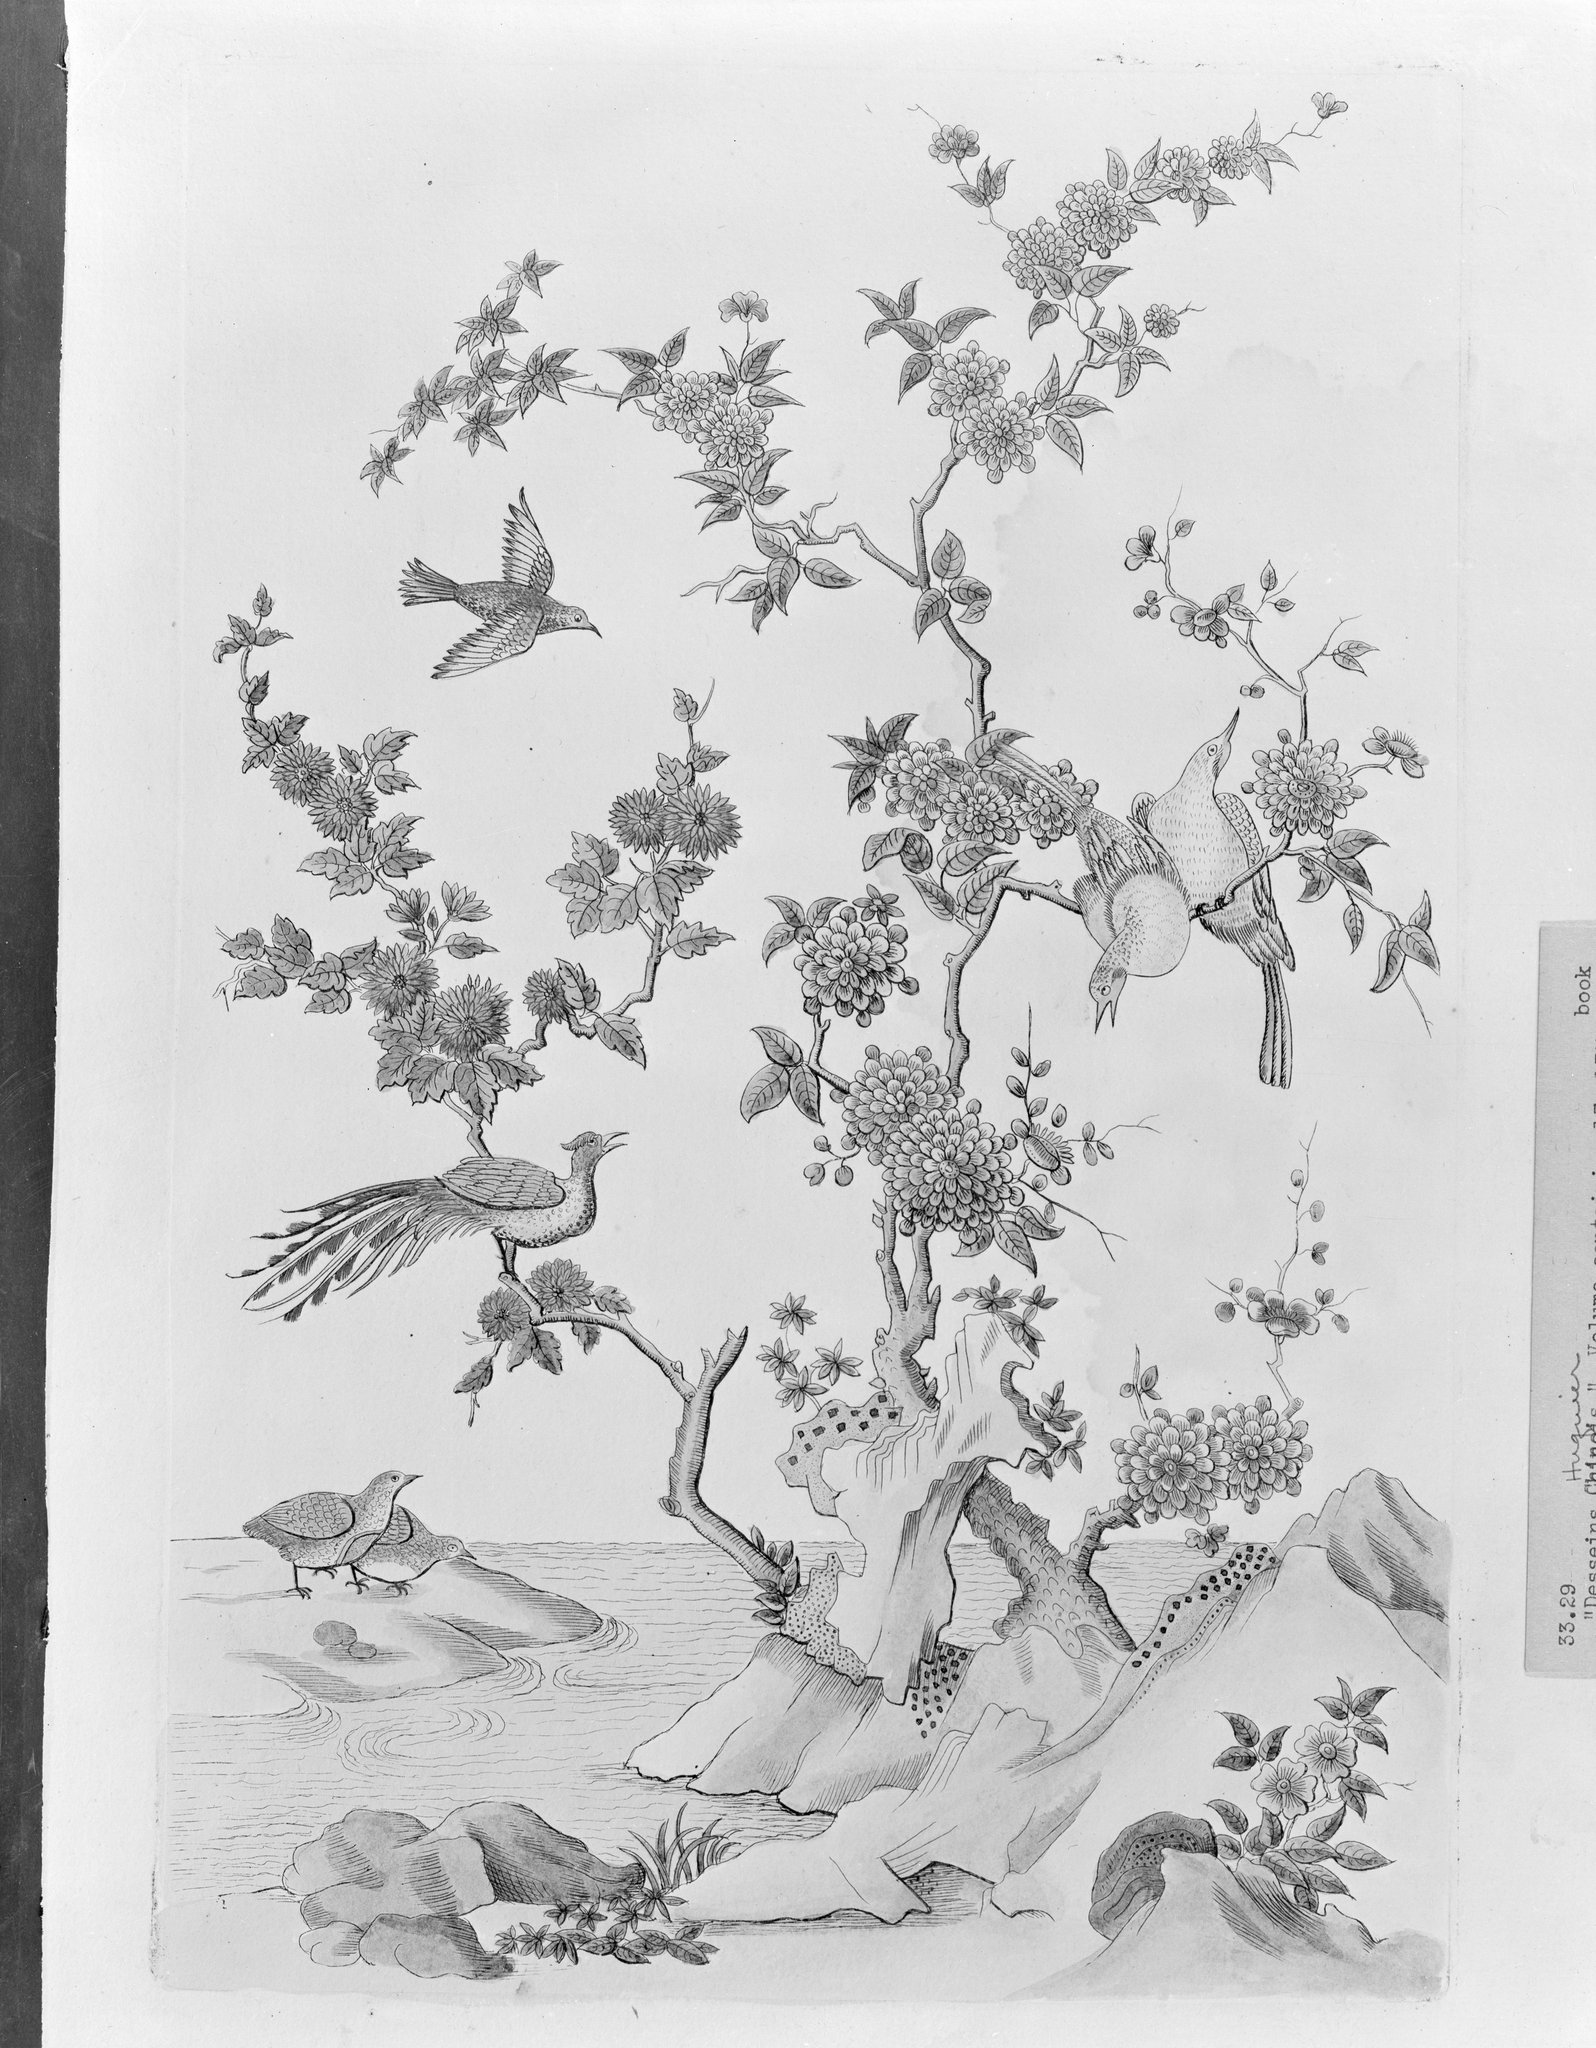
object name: book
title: [Book of different species of birds, flowers, plants, and trophies of China]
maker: gabriel huquier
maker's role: artist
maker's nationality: french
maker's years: 1695-1772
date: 1701-1800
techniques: engraving, hand coloring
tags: birds,plants